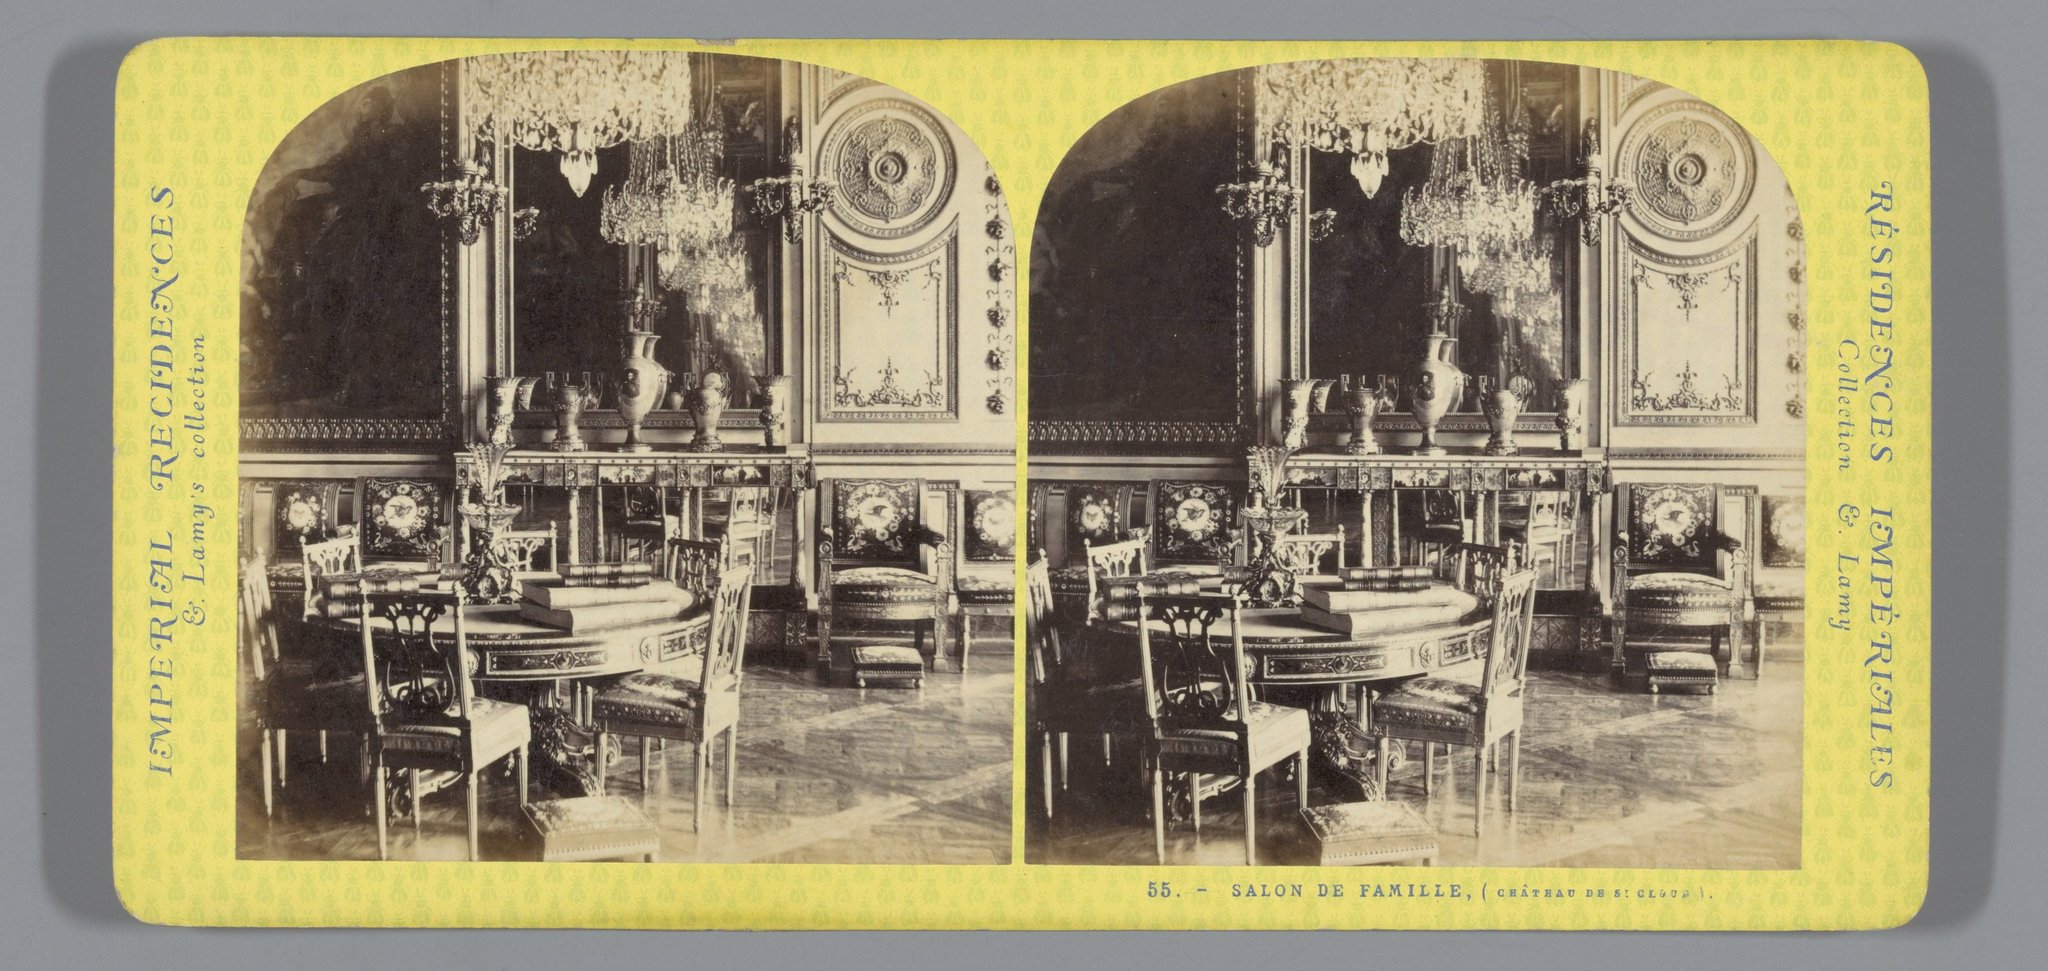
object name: stereograph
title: Salon de Famille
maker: ernest eléonor pierre lamy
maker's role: publisher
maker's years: 1828-1900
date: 1860-1870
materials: cardboard, photographic support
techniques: albumen print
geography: château de saint-cloud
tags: drawing-room, 'salon', castle, interior ~ representation of a building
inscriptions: number: ‘55.’, inscription: ‘E. Lamy's collection’